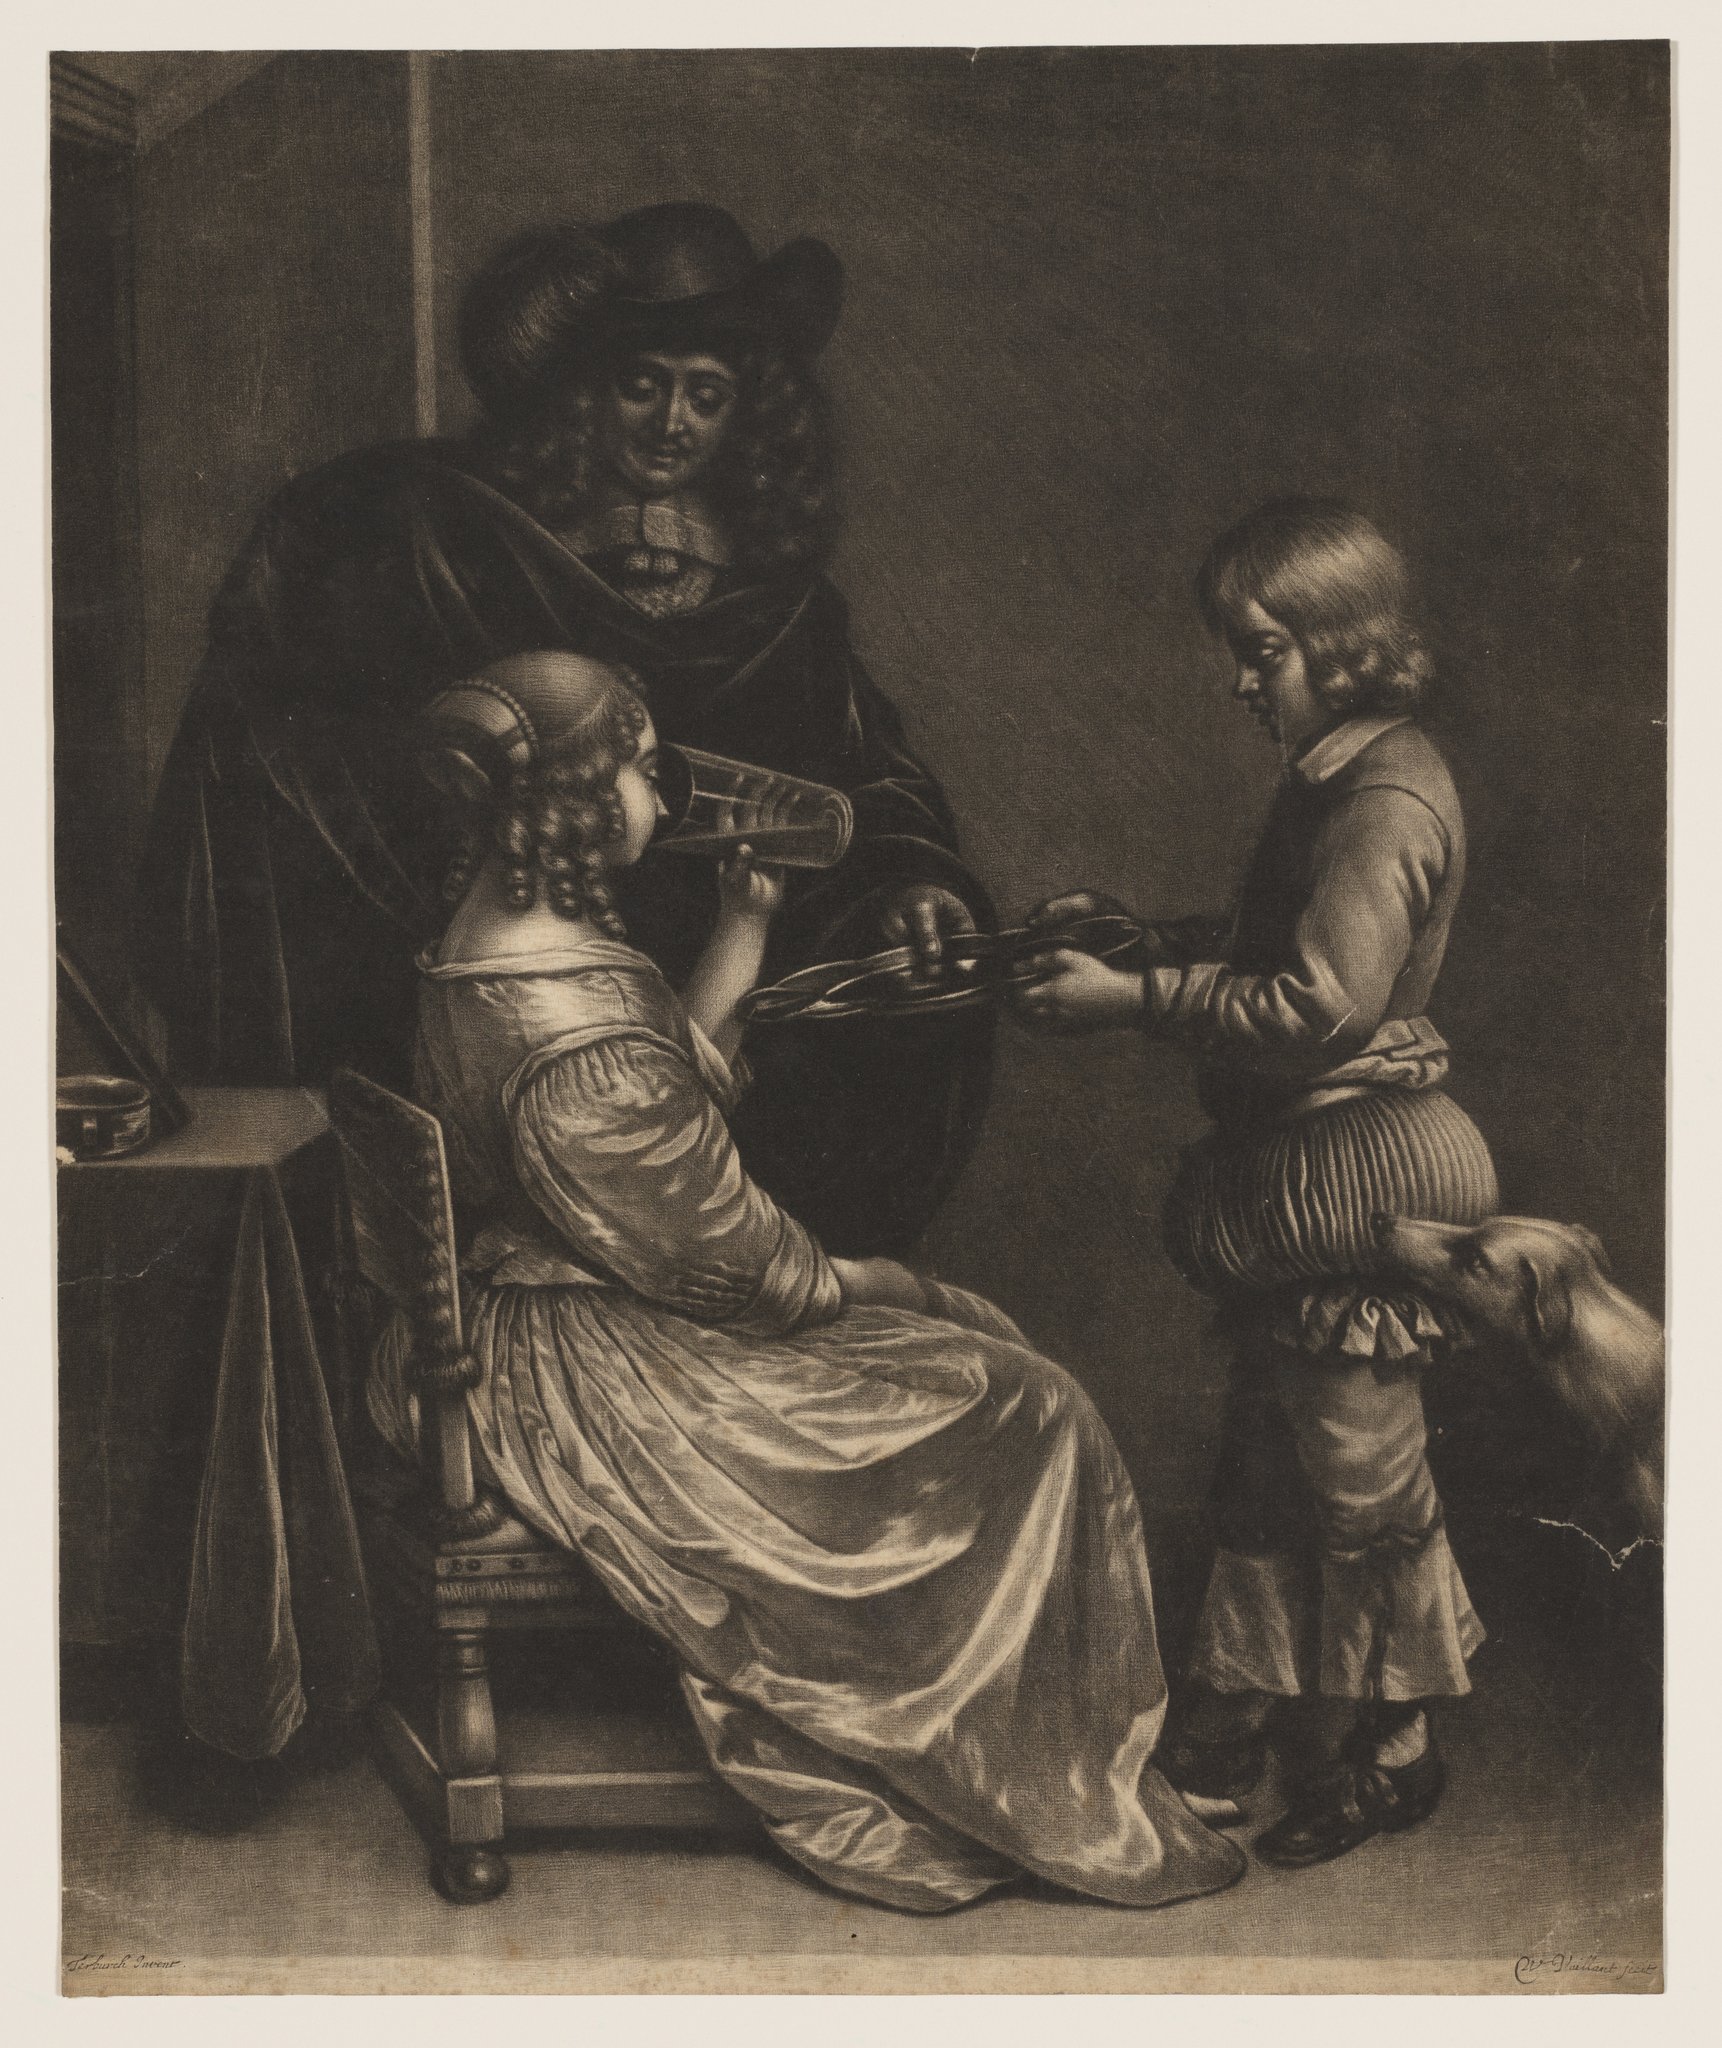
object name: print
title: The Drinking Lady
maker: wallerant vaillant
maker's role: artist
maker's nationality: dutch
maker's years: 1623-1677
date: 1601-1700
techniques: mezzotint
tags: boys,men,women,dogs,drinking